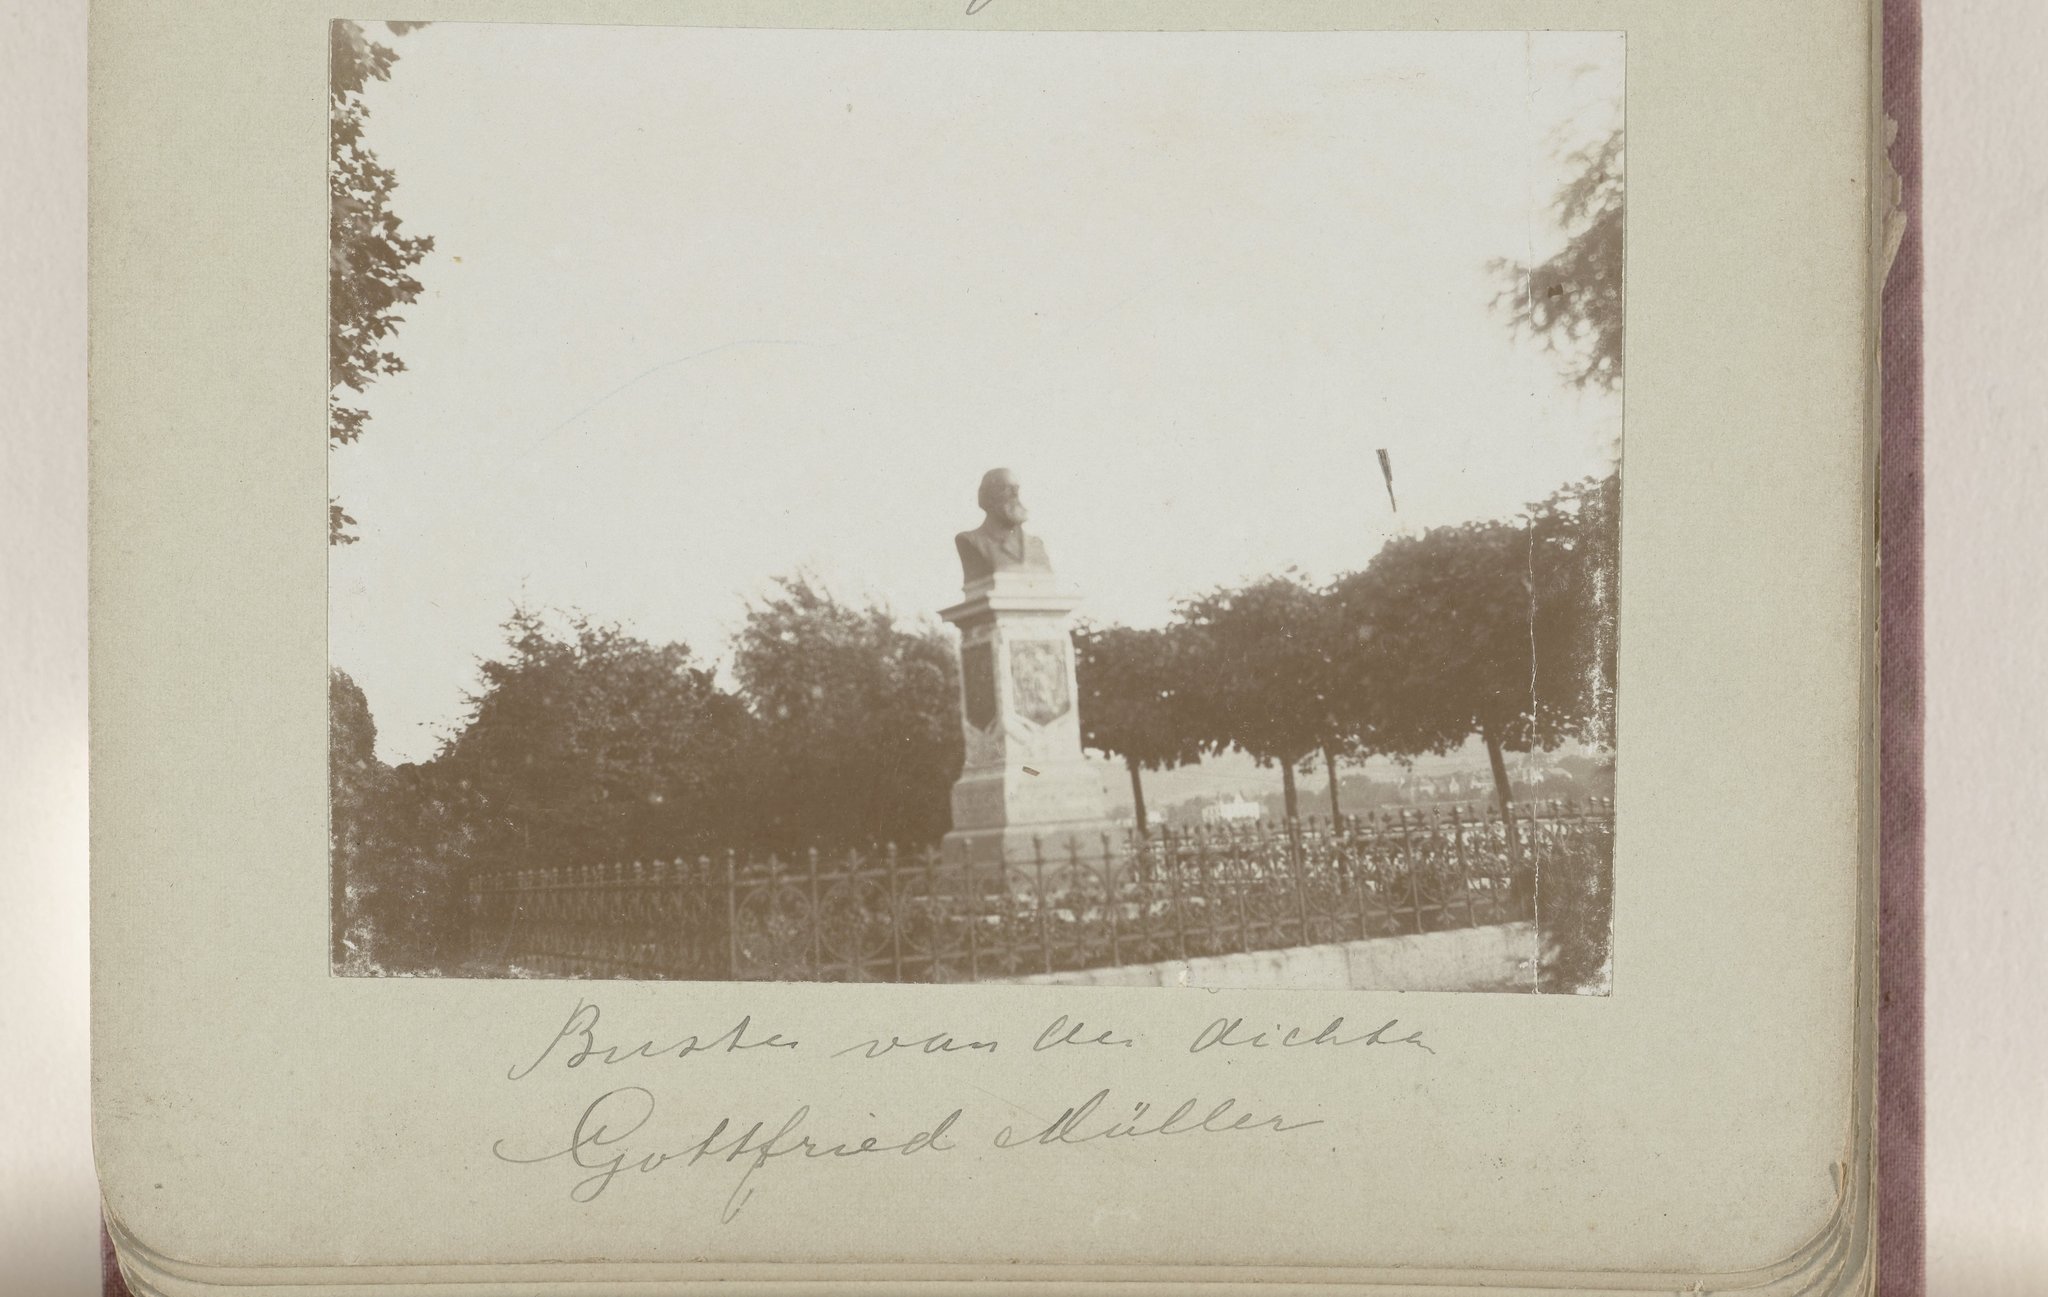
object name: album leaf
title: Buste van den dichter Gottfried Müller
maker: david vermeulen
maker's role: fotograaf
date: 1895-1905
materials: paper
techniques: collodion silver print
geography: königswinter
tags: politician, monument, statue